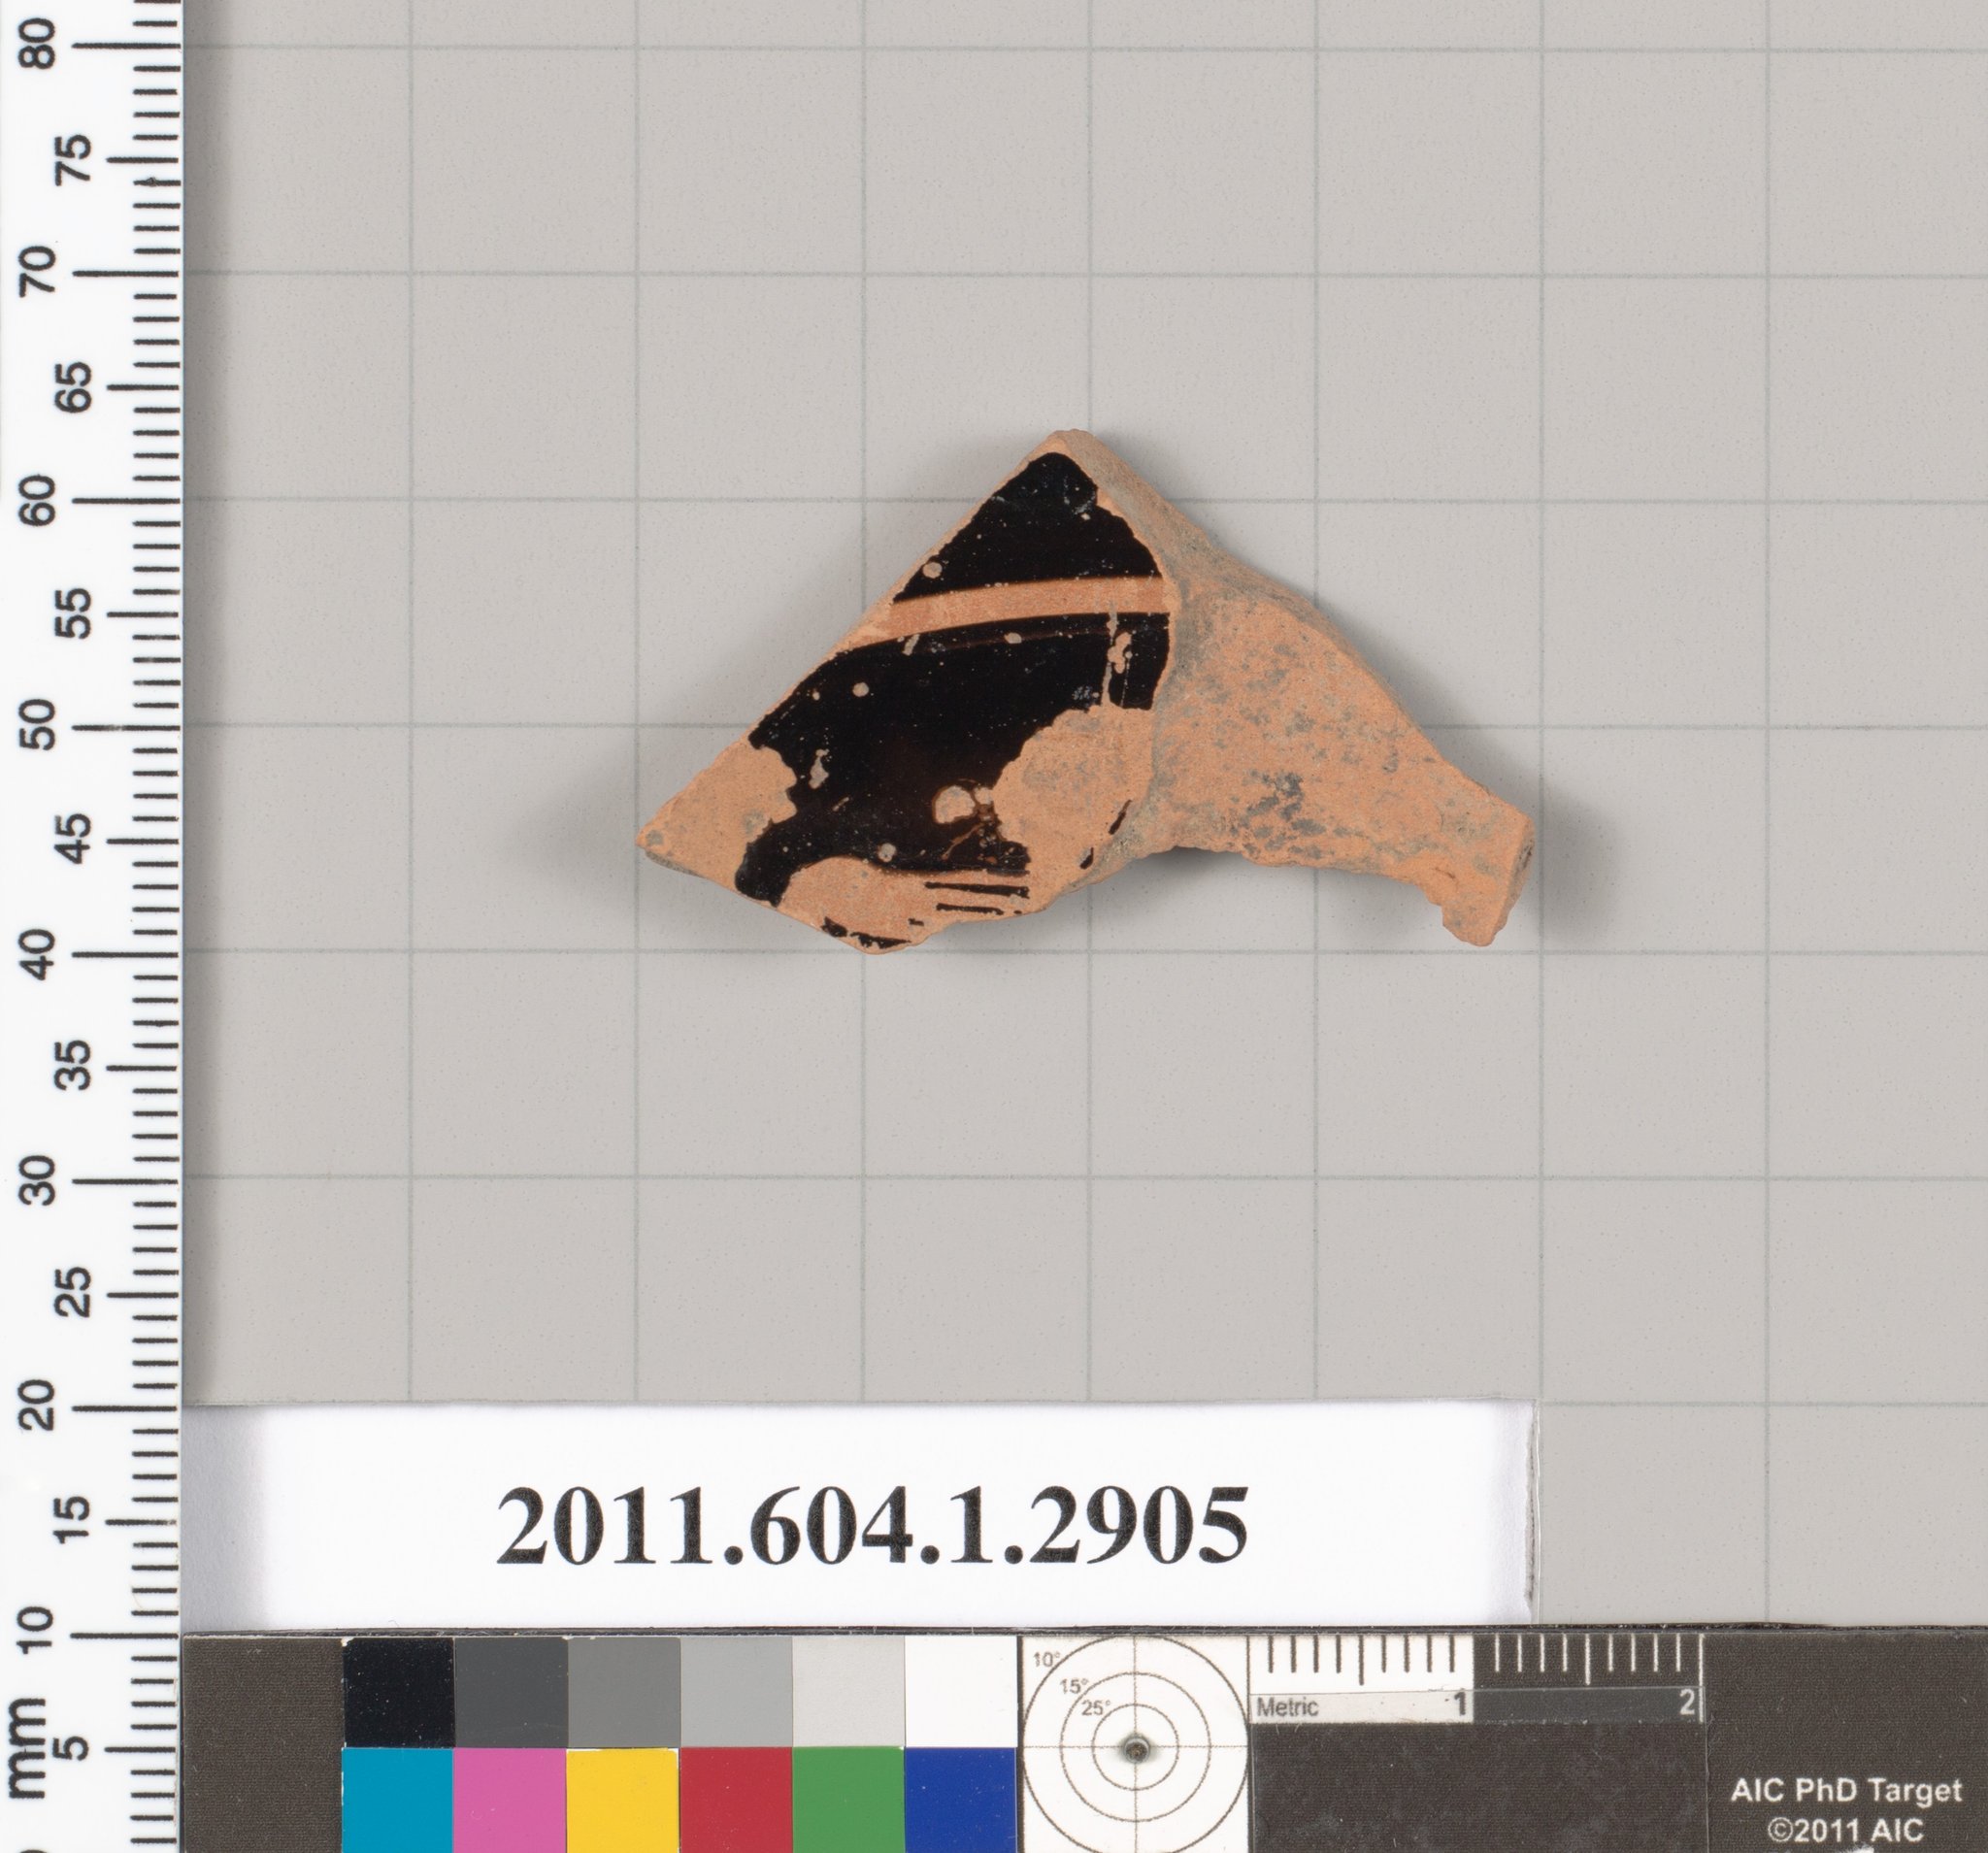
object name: kylix fragment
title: Terracotta fragment of a kylix (drinking cup)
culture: greek, attic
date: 520-500 BCE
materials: terracotta